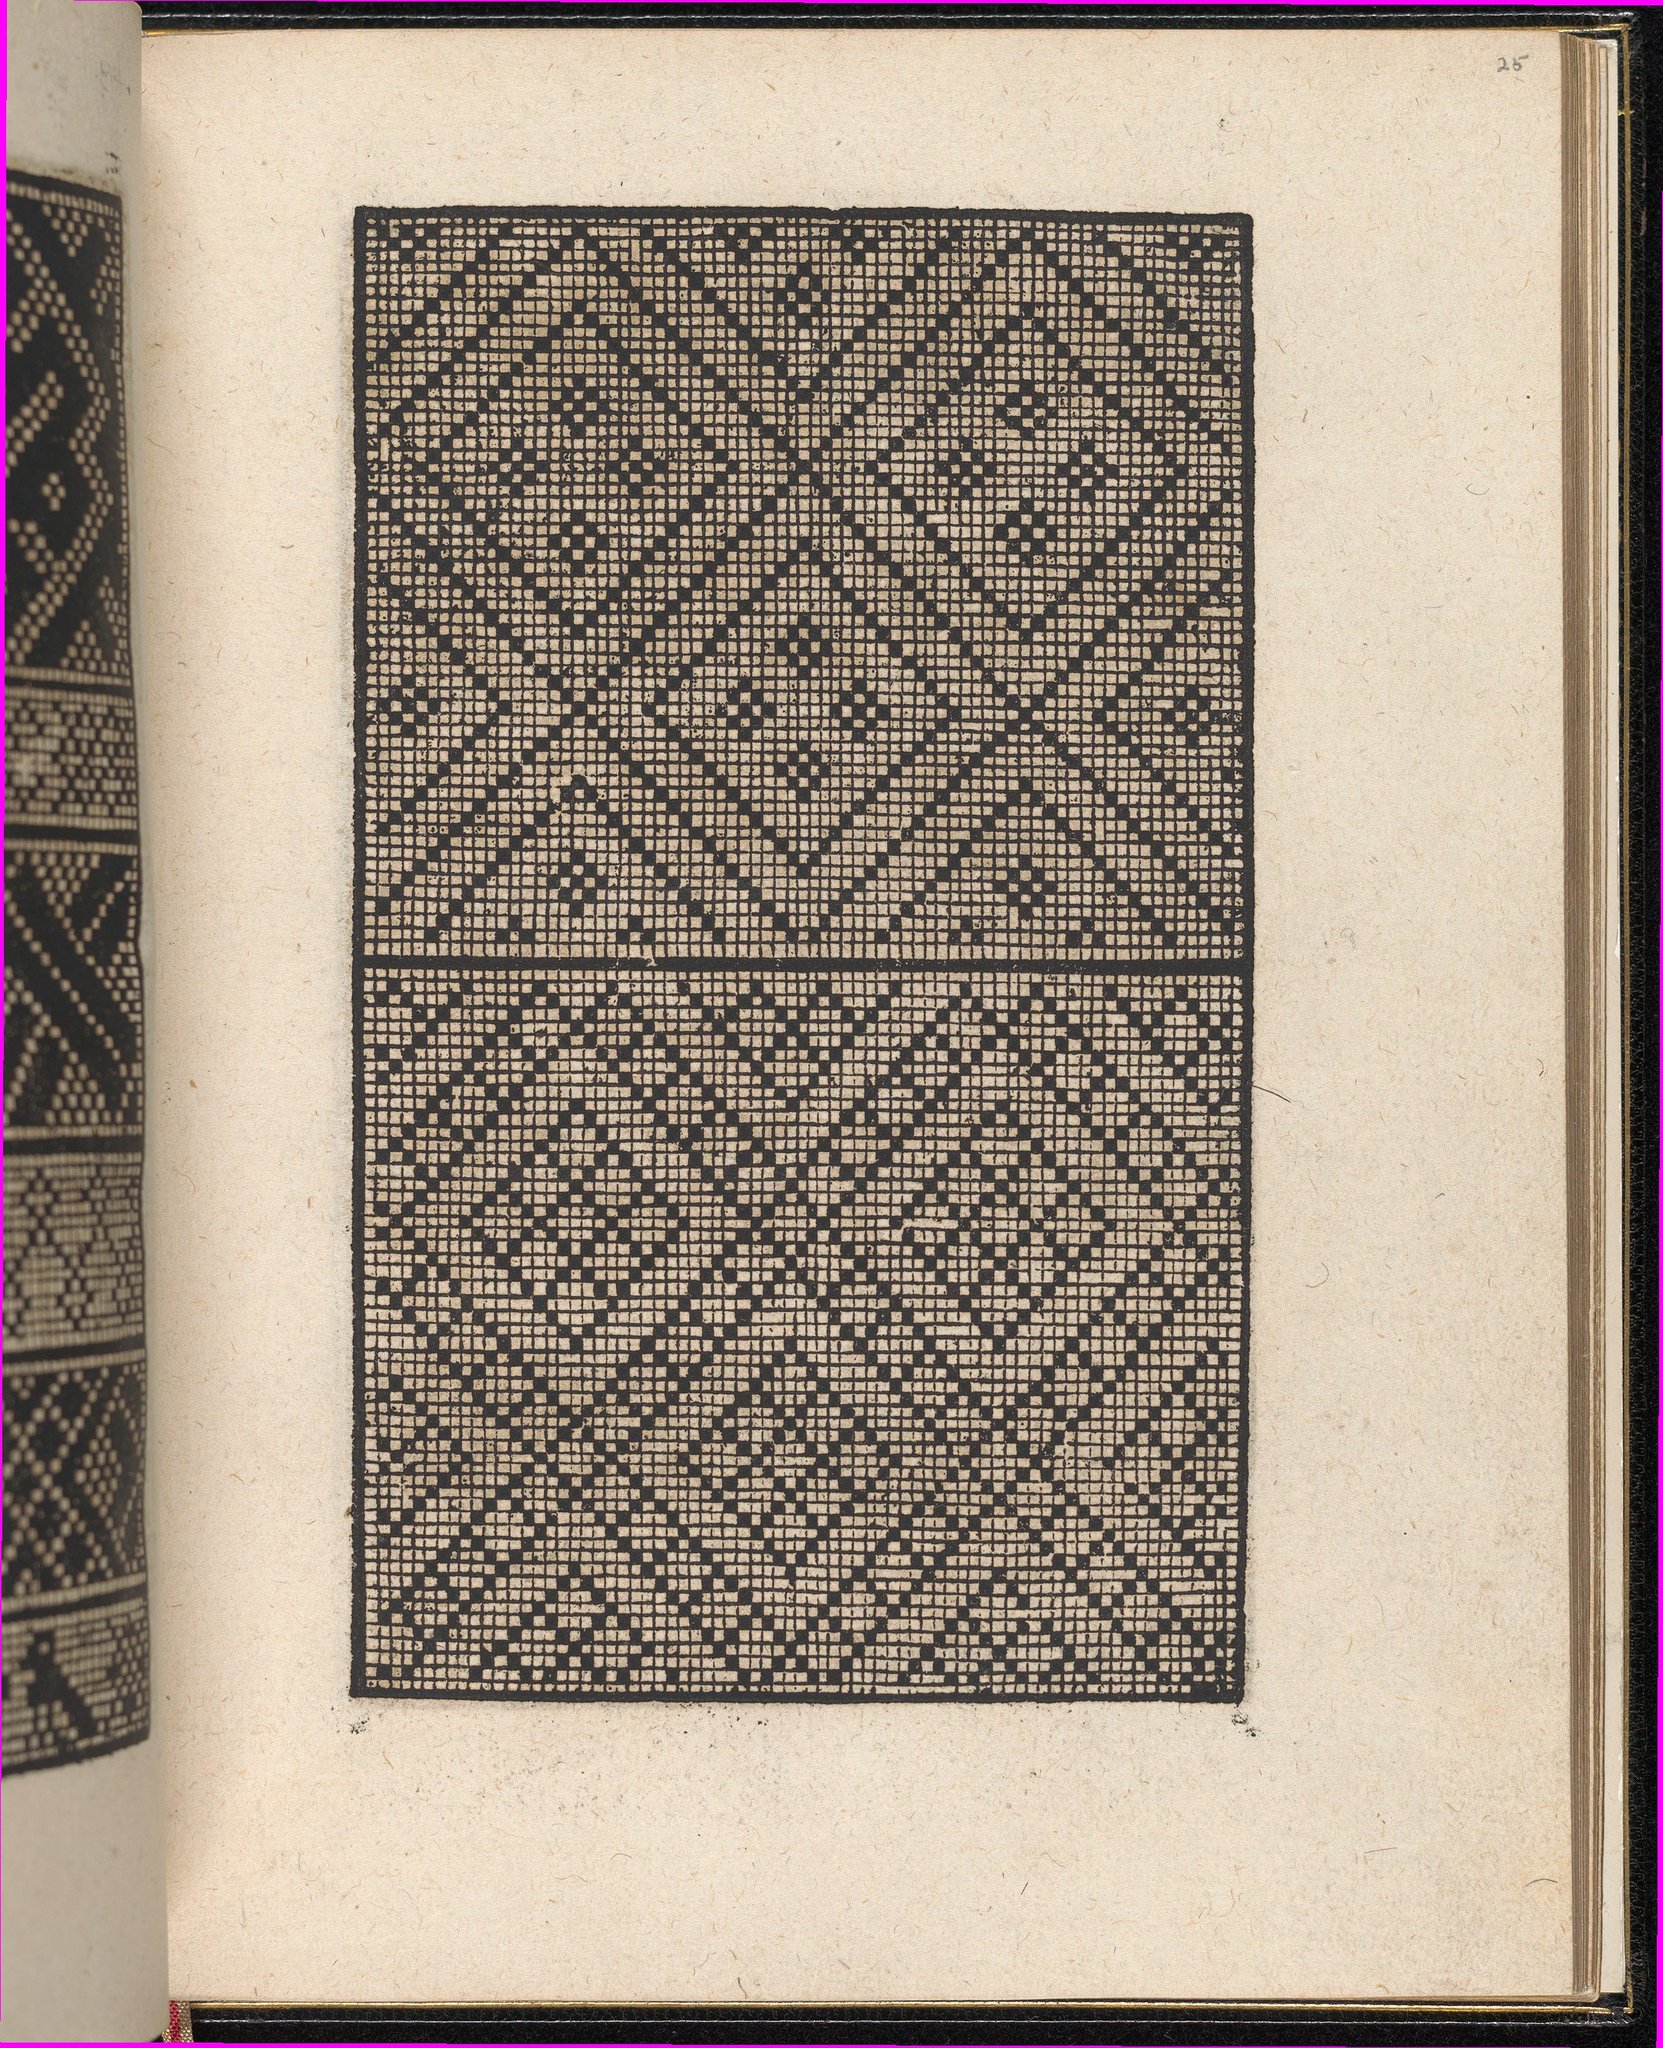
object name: book print ornament architecture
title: Page from Ein new kunstlich Modelbuch...(Page 25r)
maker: peter quentel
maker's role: publisher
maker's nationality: german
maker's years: 1500-1550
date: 1544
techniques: woodcut